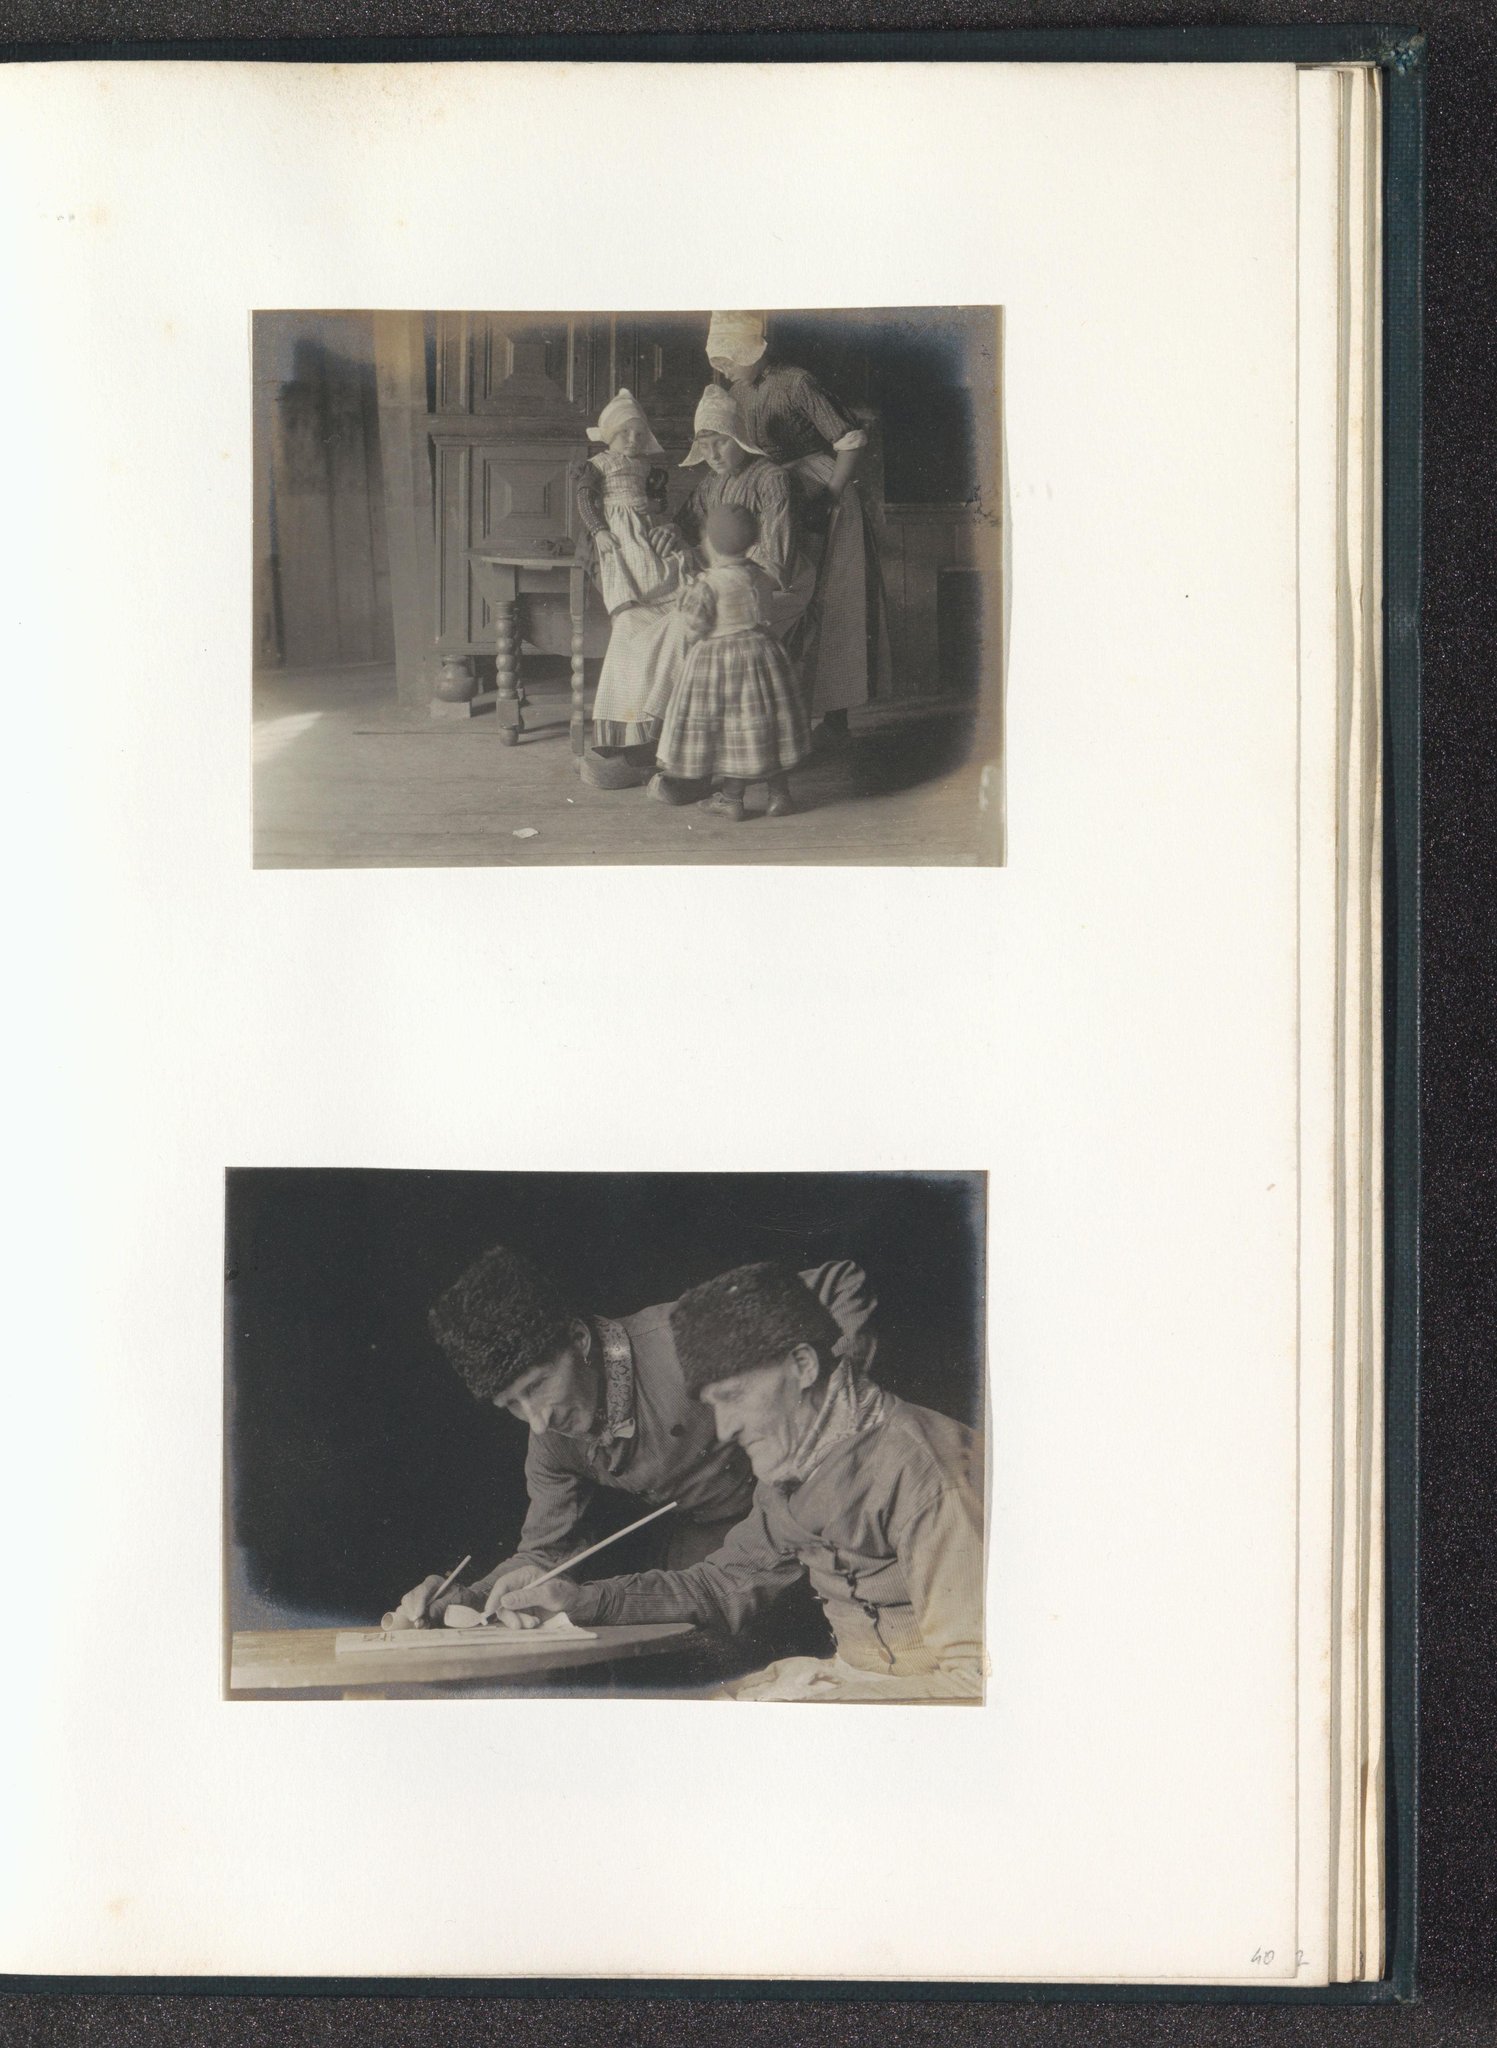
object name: photograph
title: Portret van twee mannen in Volendamse klederdracht, zittend aan een tafel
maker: george hidderley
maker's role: fotograaf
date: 1900-1910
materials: paper, photographic support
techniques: gelatin silver print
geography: volendam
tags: sitting figure, pipe ~ tobacco, folk costume, regional costume, reading to somebody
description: Onderdeel van fotoalbum met opnames van Volendam, Dordrecht, Gorinchem en Woudrichem.